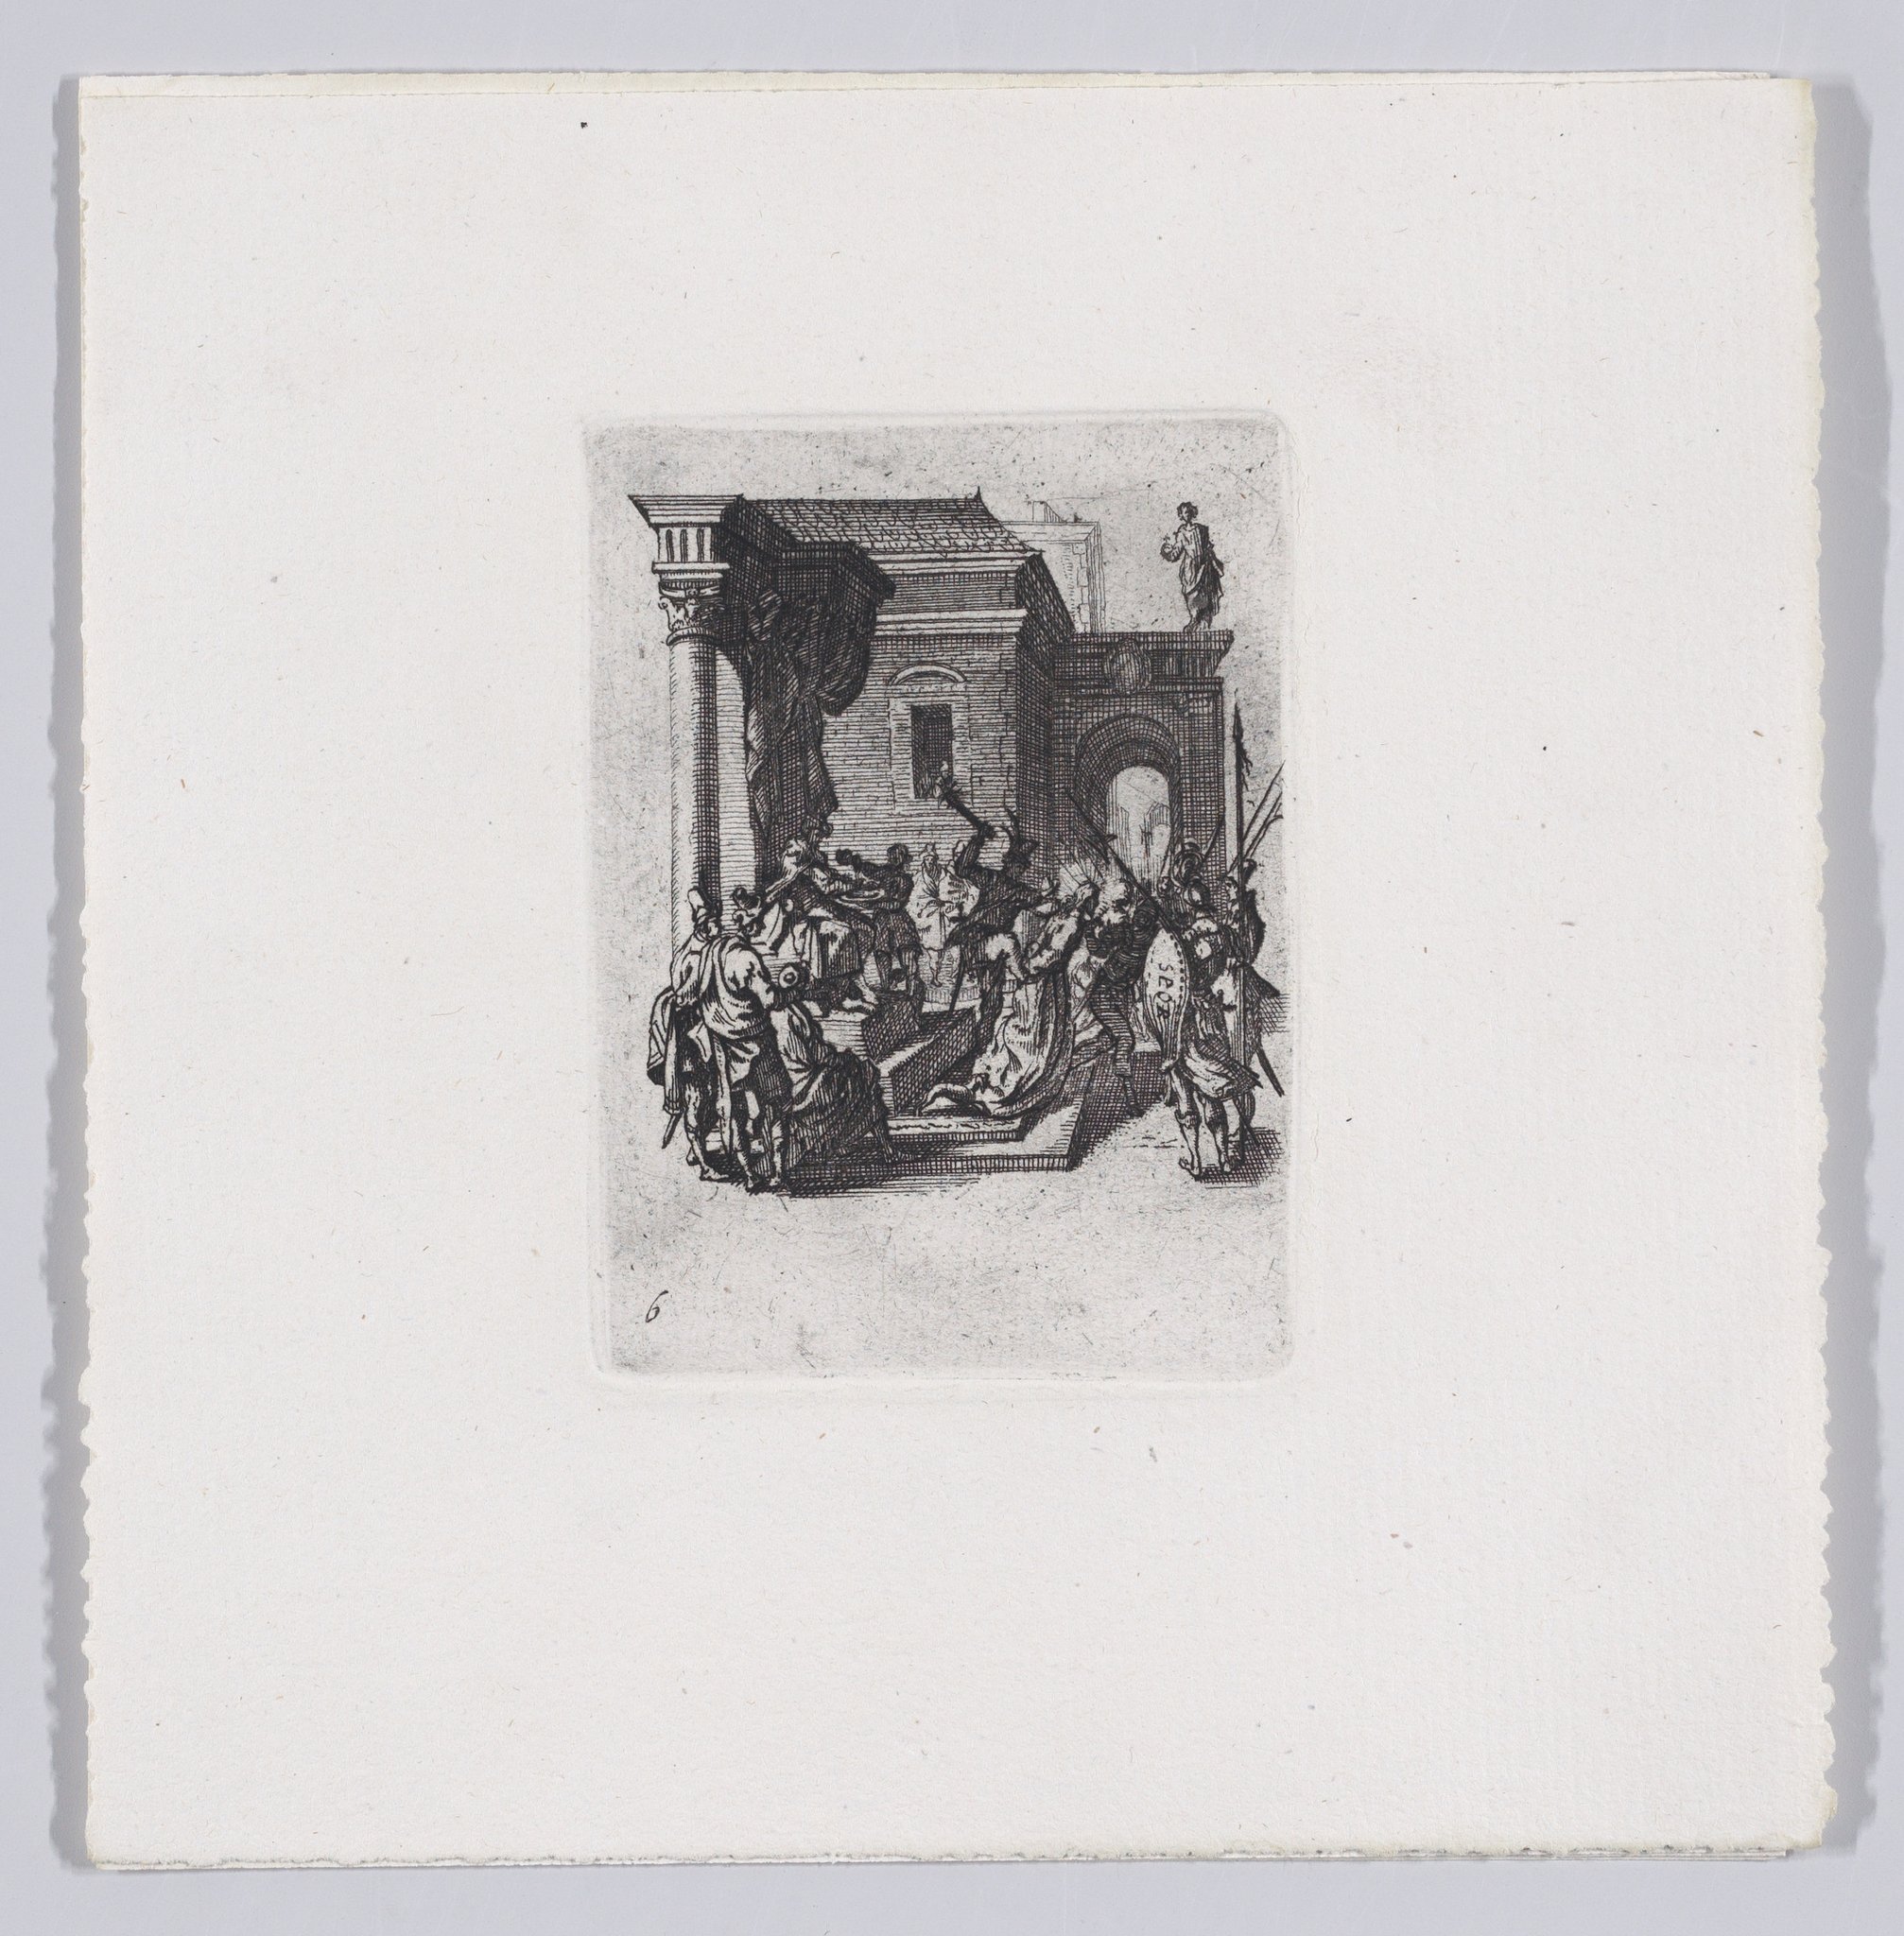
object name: print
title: Reverse Copy of La Condamnation a Mort (Jesus Sentenced to Death), from La Petite Passion (The Little Passion)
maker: Anonymous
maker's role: artist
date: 1601-1700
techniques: etching